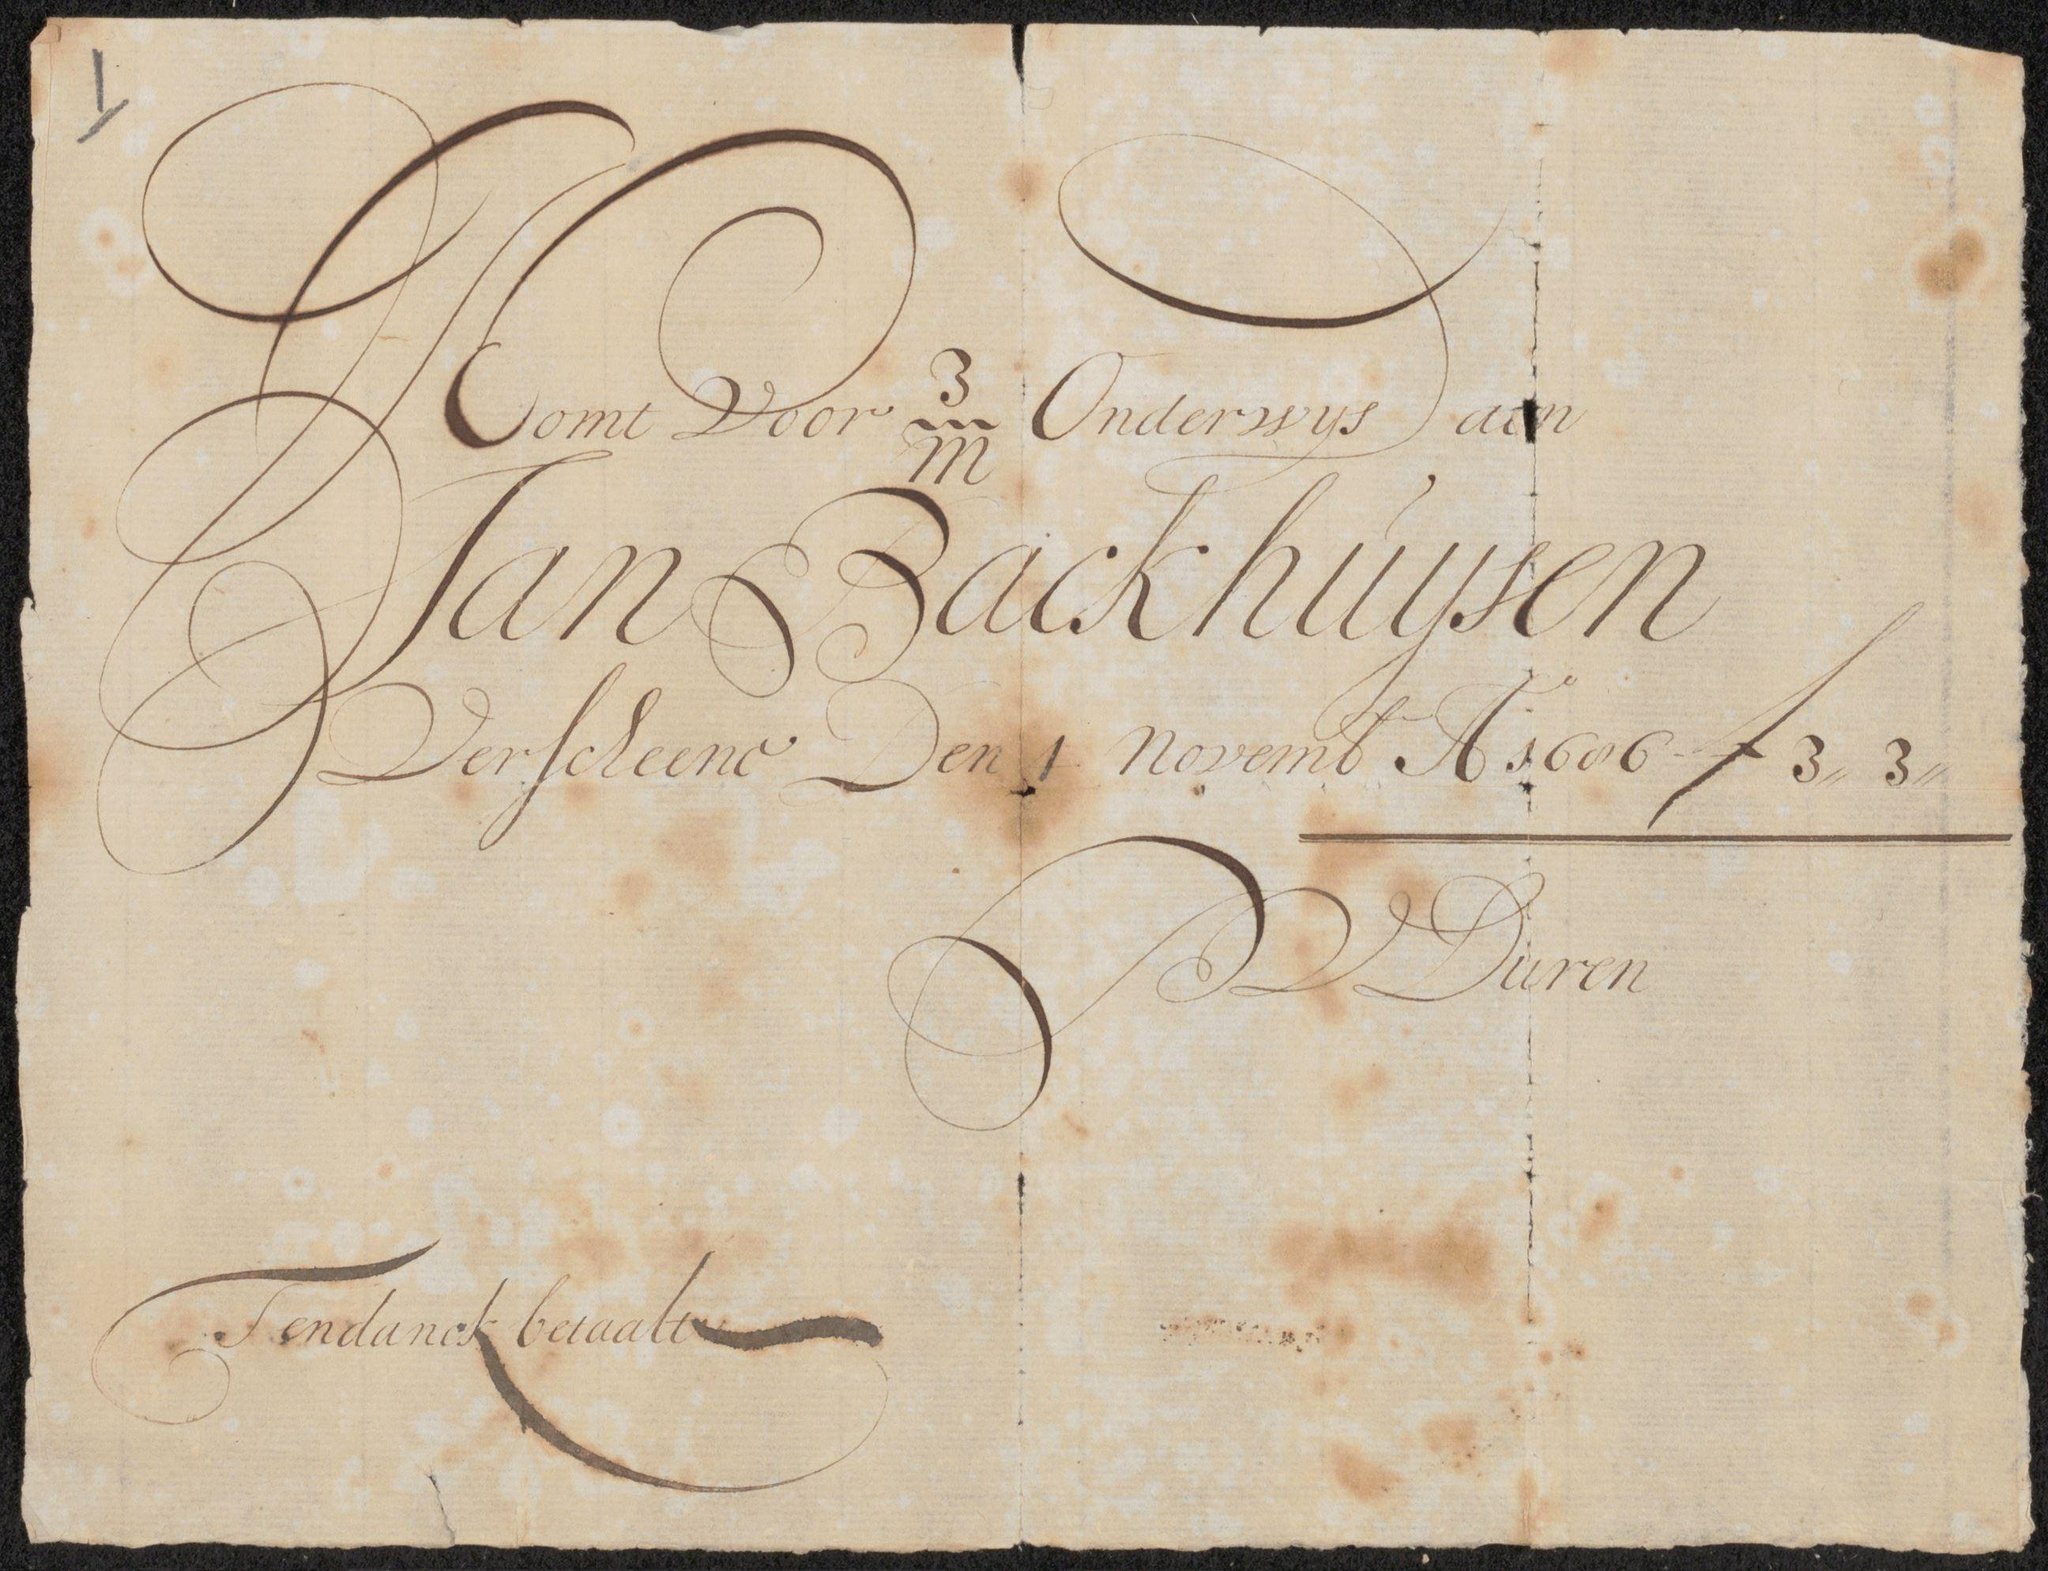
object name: ontvangstbewijs, kwitantie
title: Kwitantie voor Jan Backhuysen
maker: Anonymous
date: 1686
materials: ink, paper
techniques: pen, writing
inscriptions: collector's mark: Lugt 2233